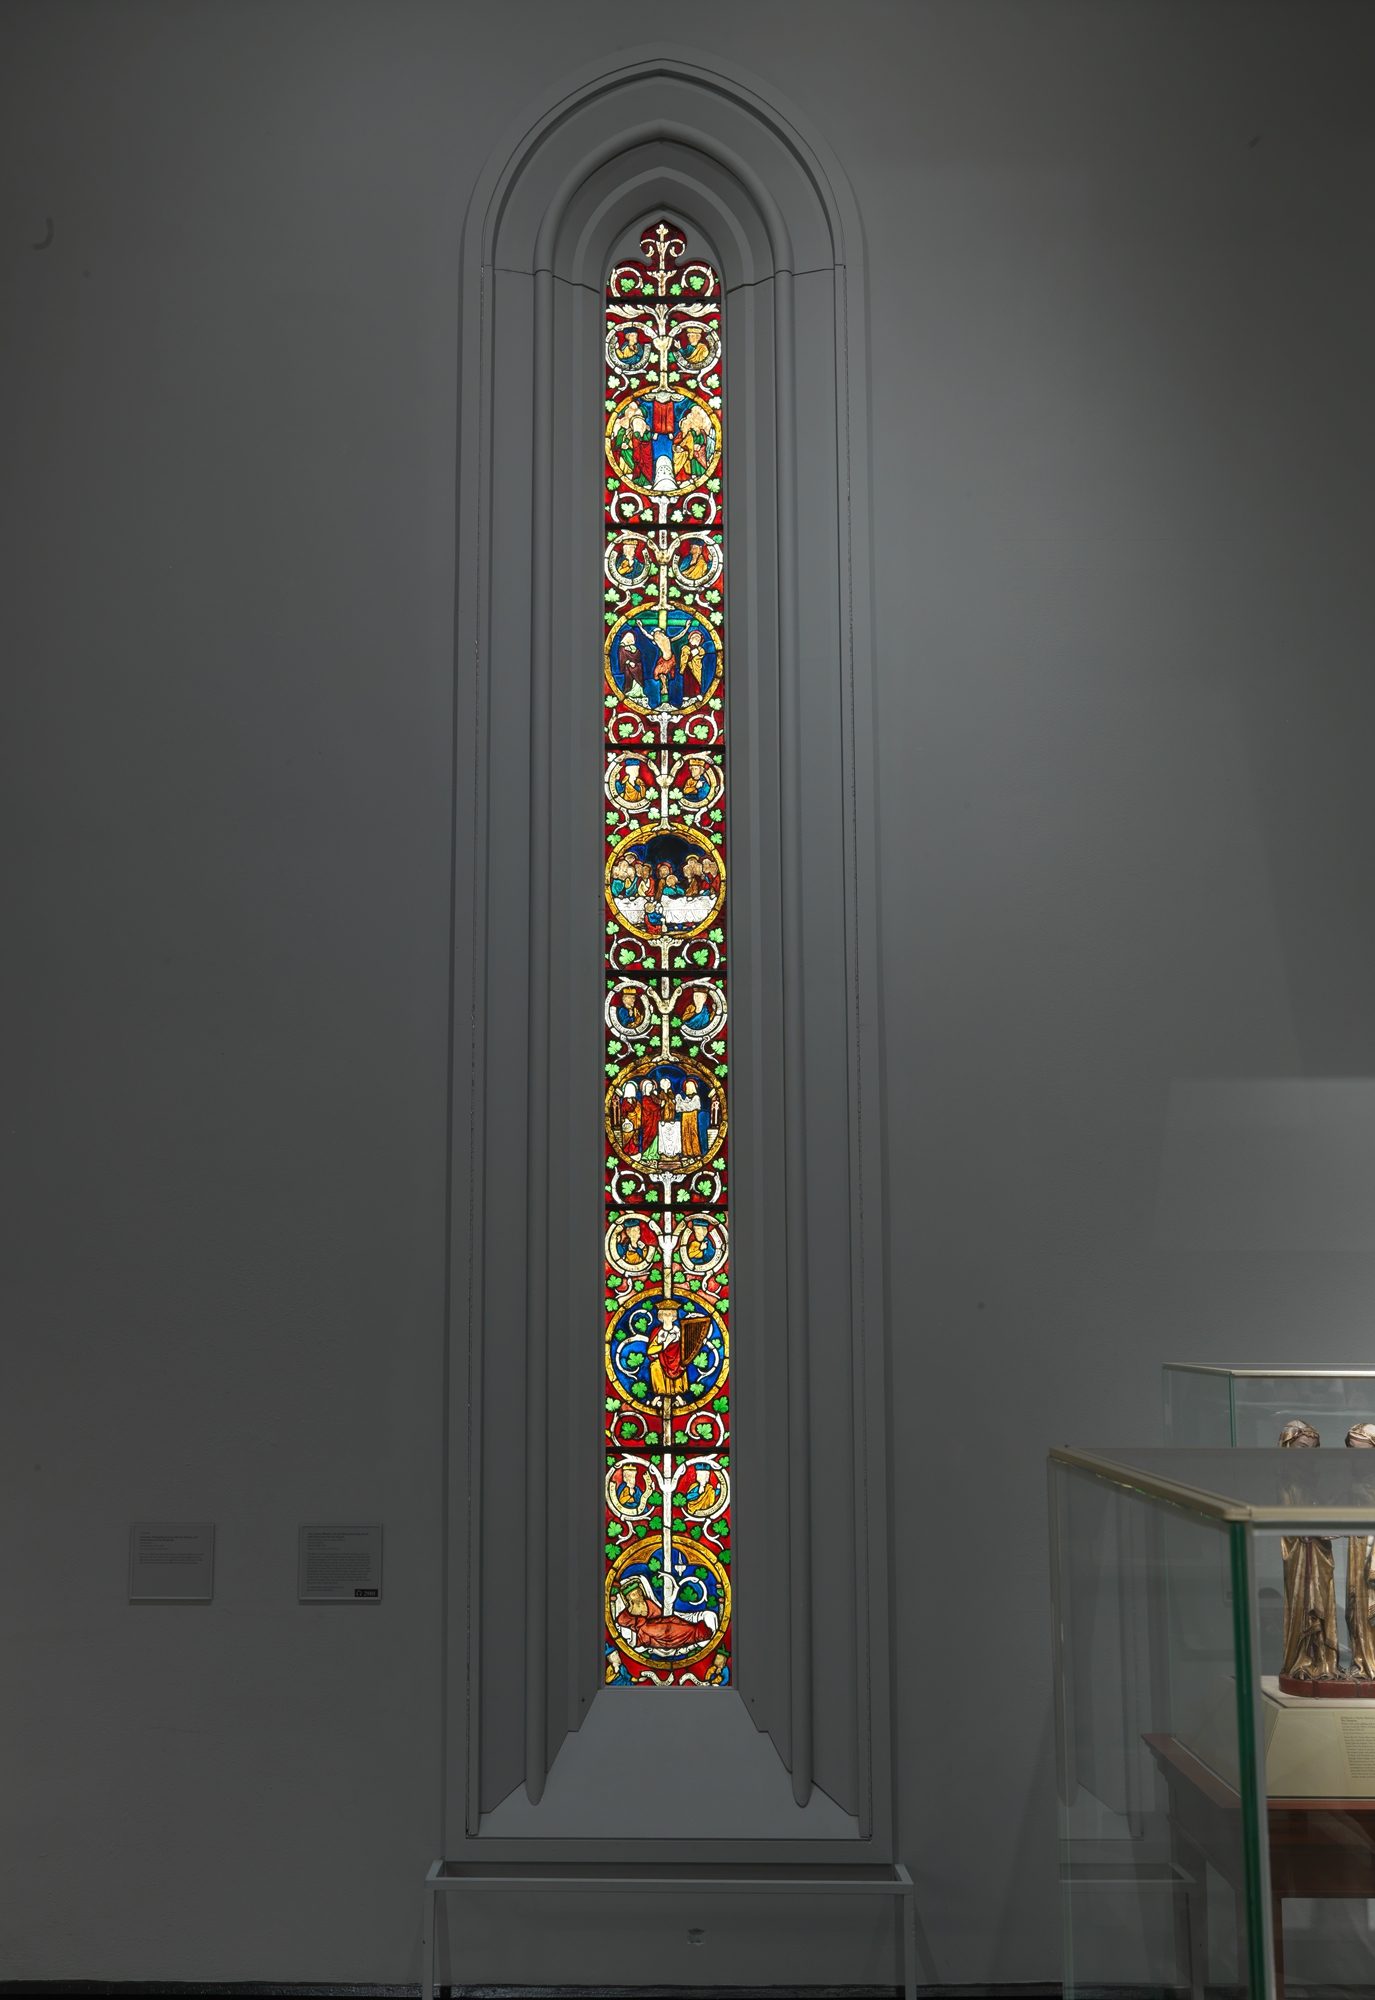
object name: panel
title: Tree of Jesse Window: The Reclining Jesse, King David, and Scenes from the Life of Jesus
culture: german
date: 1280-1300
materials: glass, lead, metal, paint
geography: germany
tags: apostles,christ,david,crucifixion,last supper